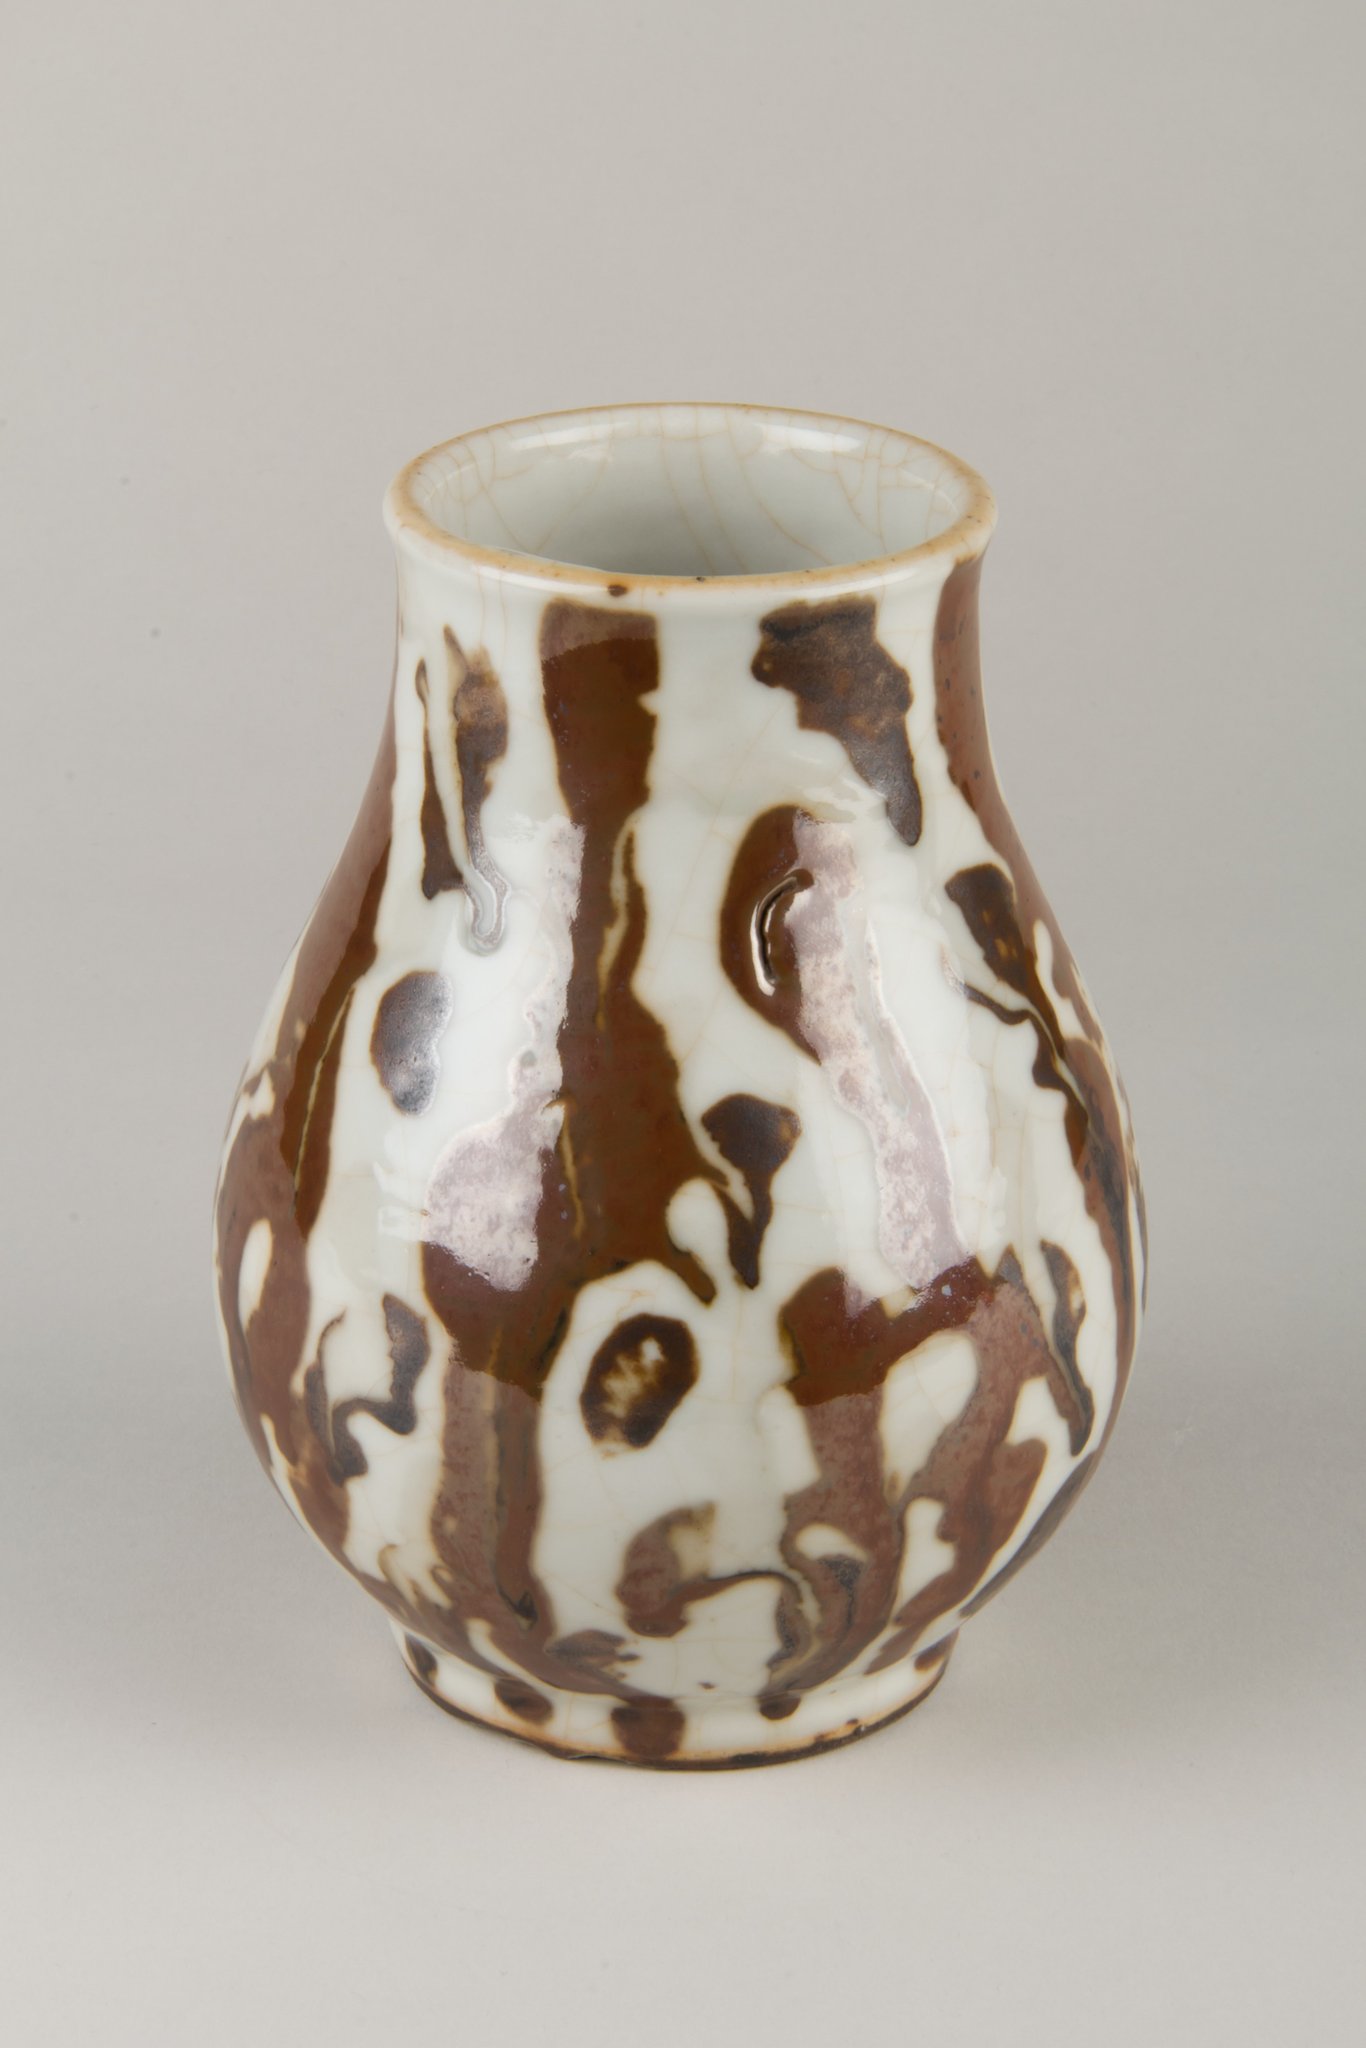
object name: vase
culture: chinese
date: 1801-1850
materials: glaze, porcelain